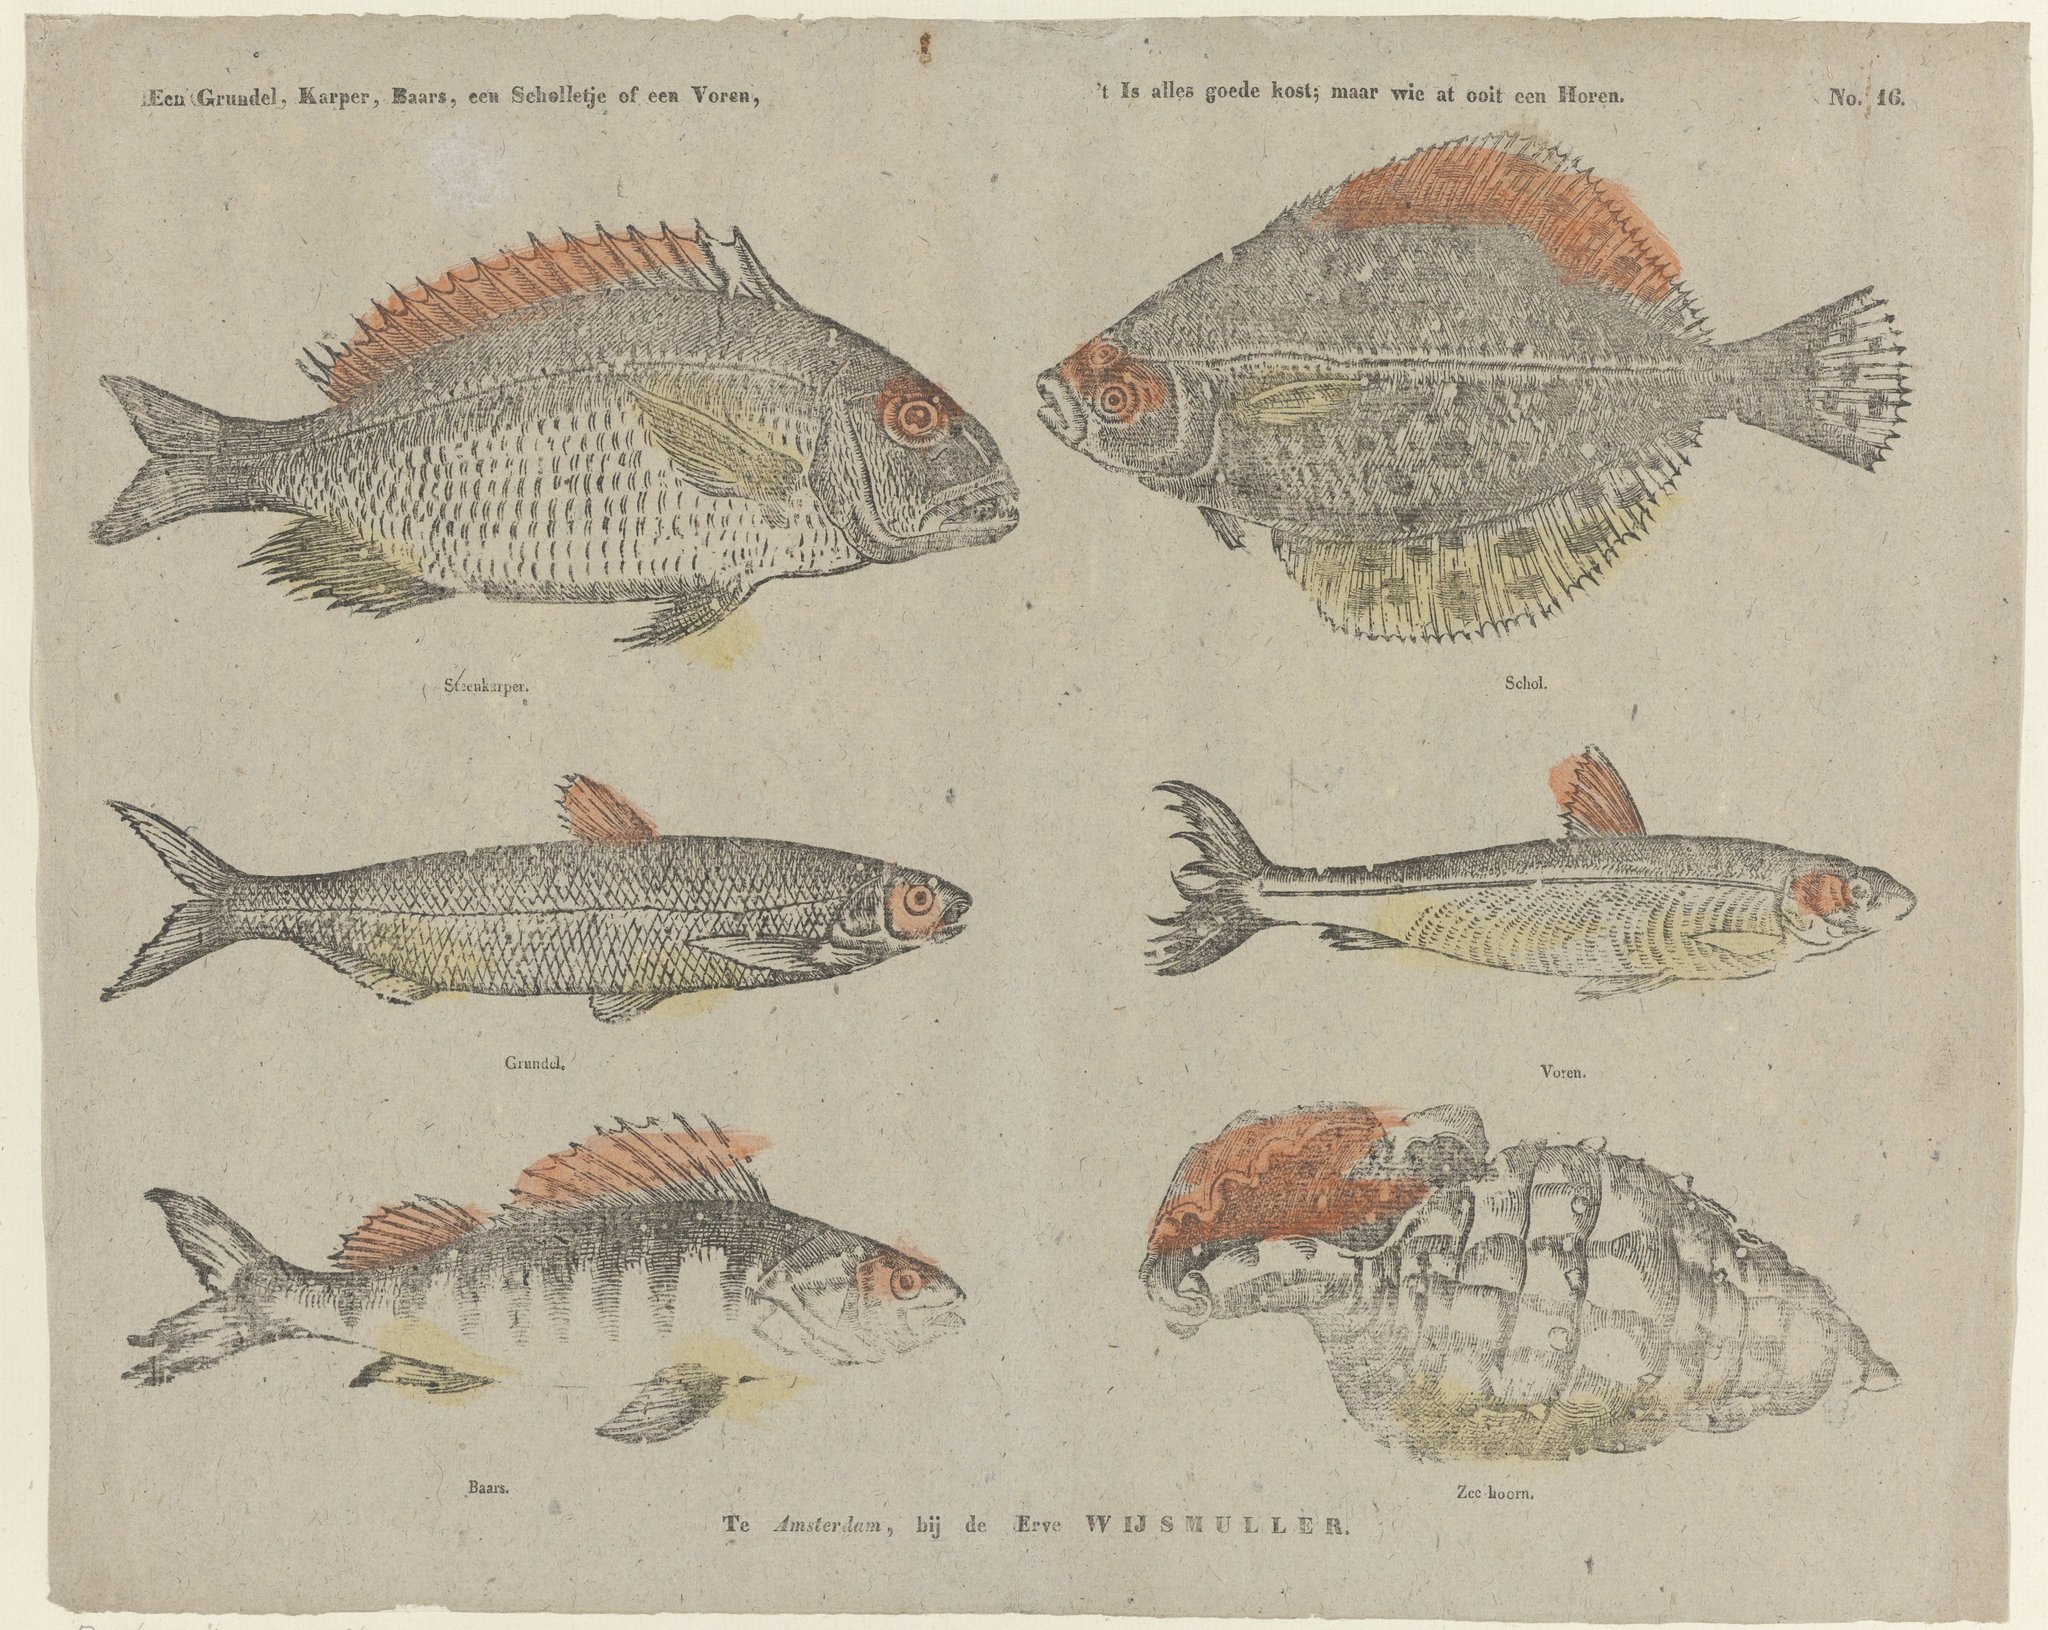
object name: print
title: Een grundel, karper, baars, een scholletje of een voren, / 't Is als goede kost, maar wie at ooit een horen?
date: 1558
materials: paper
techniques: colour, letterpress printing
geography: rotterdam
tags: shell fishery, fishes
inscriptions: collector's mark: Lugt 2760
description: Voor het drukken van deze prent is gebruik gemaakt van bestaande houtblokken die in de zestiende eeuw gebruikt werden voor de befaamde natuurhistorische boeken van de Zwitser Conrad Gessner. Minstens een deel van de houtblokken voor de illustraties van Gessners werk bevond zich in de achttiende en vroege negentiende eeuw in Nederland. Daar werden ze benut voor het drukken van cents- of volksprenten. De nogal willekeurige kleuring op de prenten is typerend voor dit soort goedkope grafiek. Opvallend is dat de dieren in de tekstjes die onder de afbeeldingen werden toegevoegd vaak anders zijn geduid dan bij Gessner. Al deze vissen en de schelp komen voor in verschillende publicaties van Gessner, alsmede herdrukken daarvan, zoals het vierde deel van Historiae animalium (eerste uitgave 1558). Heruitgave door wederverkoper Erve Wijsmuller van nr. 16 uit de fondslijst van T.J. Wijnhoven-Hendriksen.